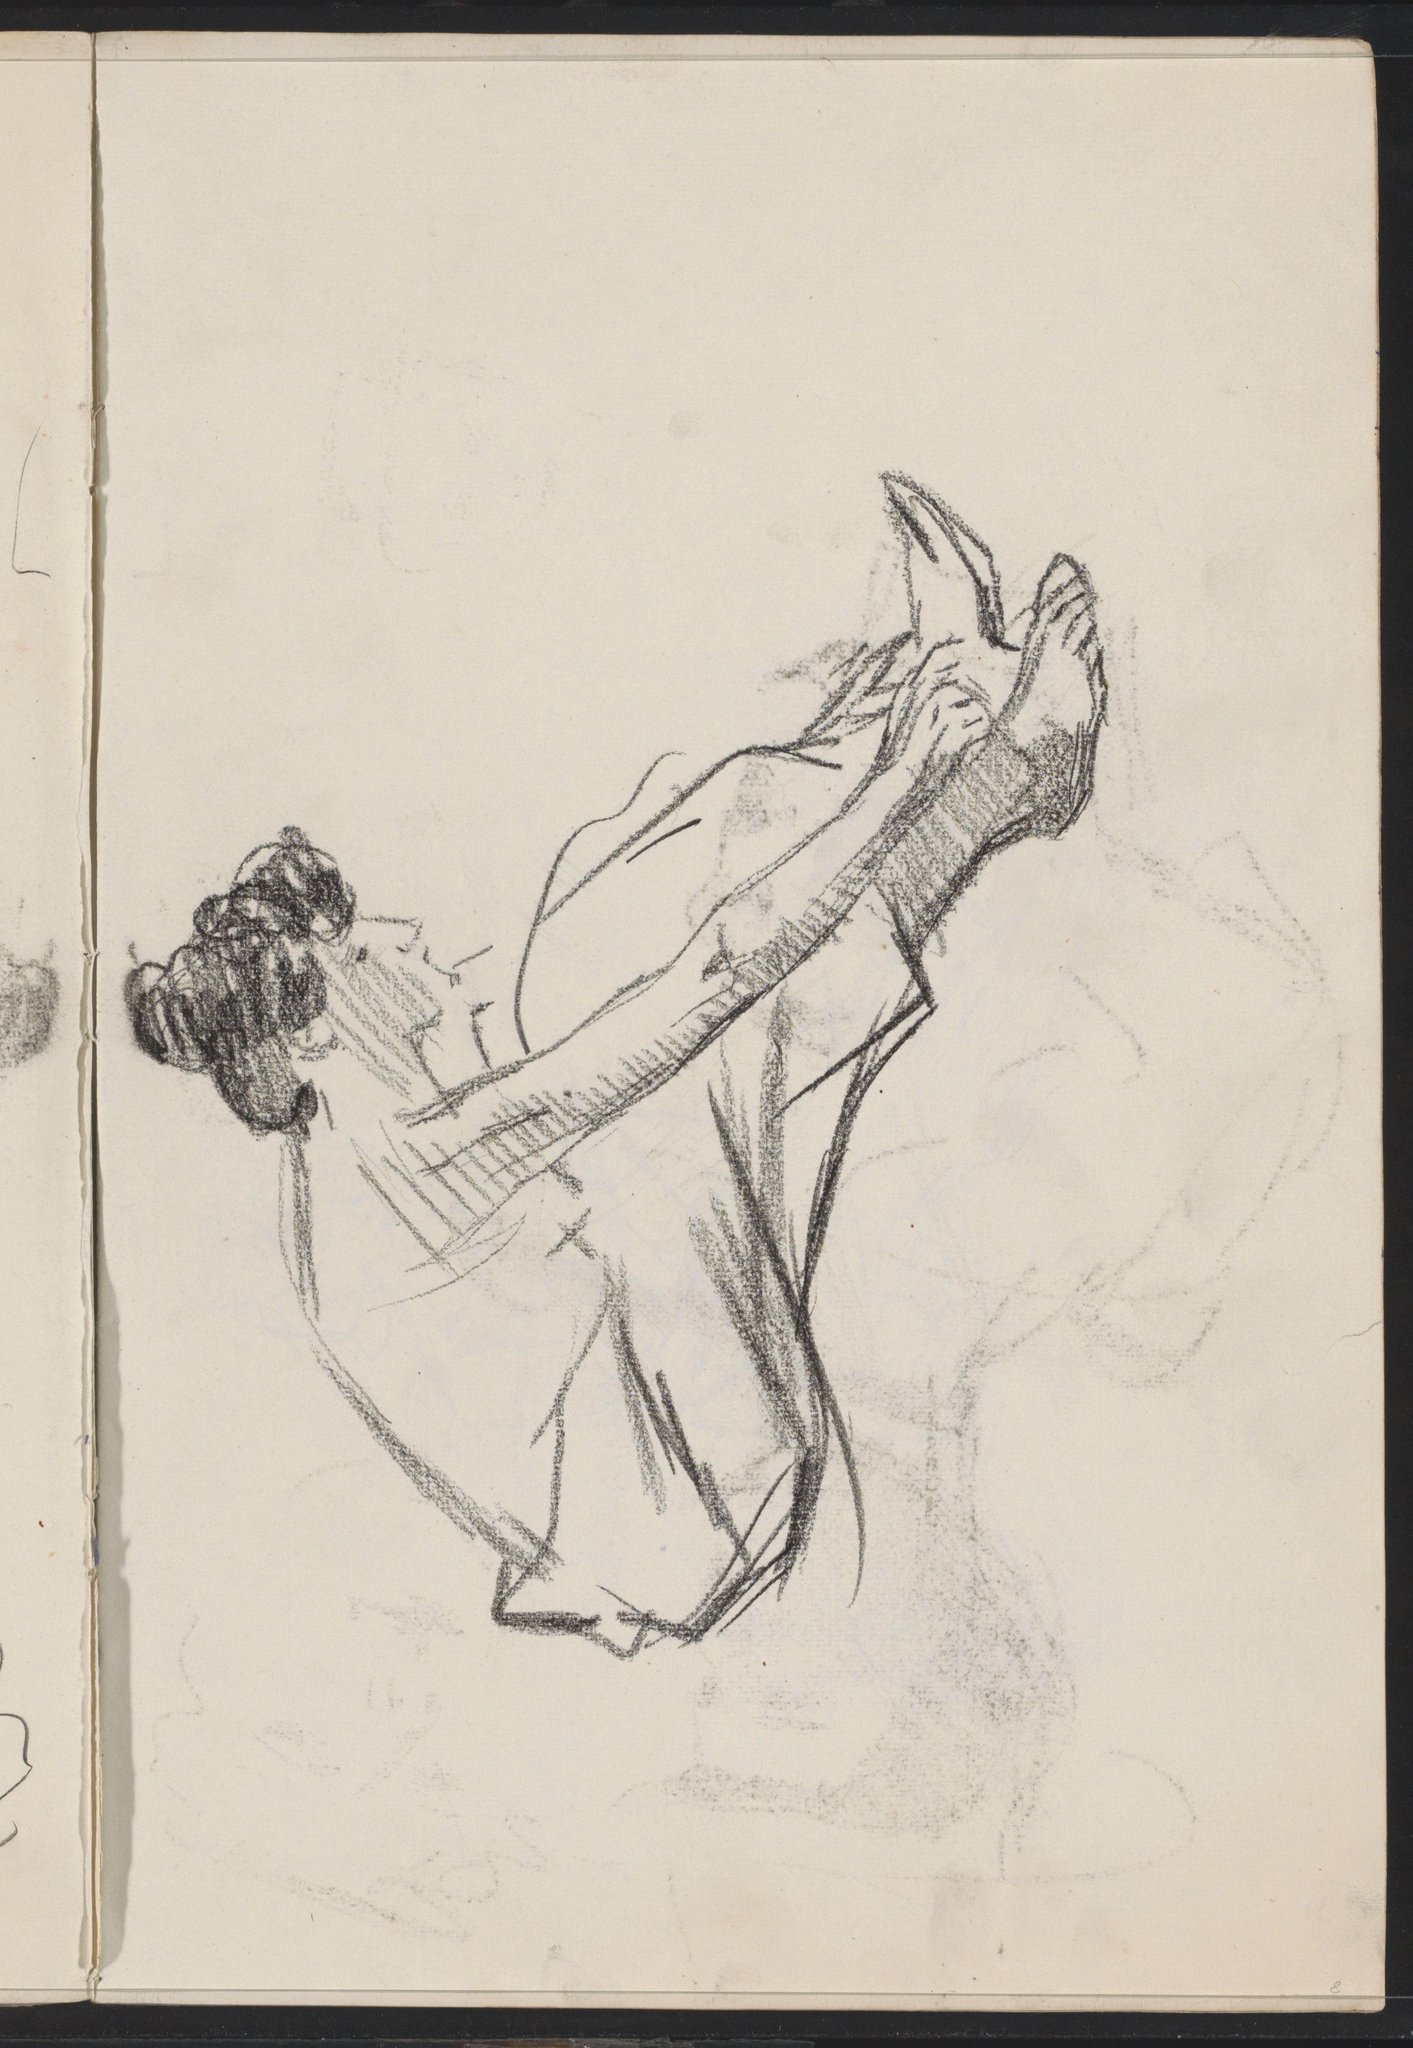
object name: sketchbook leaf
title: Zittende vrouw, naar haar voeten reikend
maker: isaac israels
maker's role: draughtsman, painter, print maker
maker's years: 1865-1934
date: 1875-1934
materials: chalk, paper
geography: the hague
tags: sitting figure - aa - female human figure, leaning forward - aa - female human figure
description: Met ontbloot bovenlijf. Blad 8 recto uit schetsboek LXIX met 25 bladen.